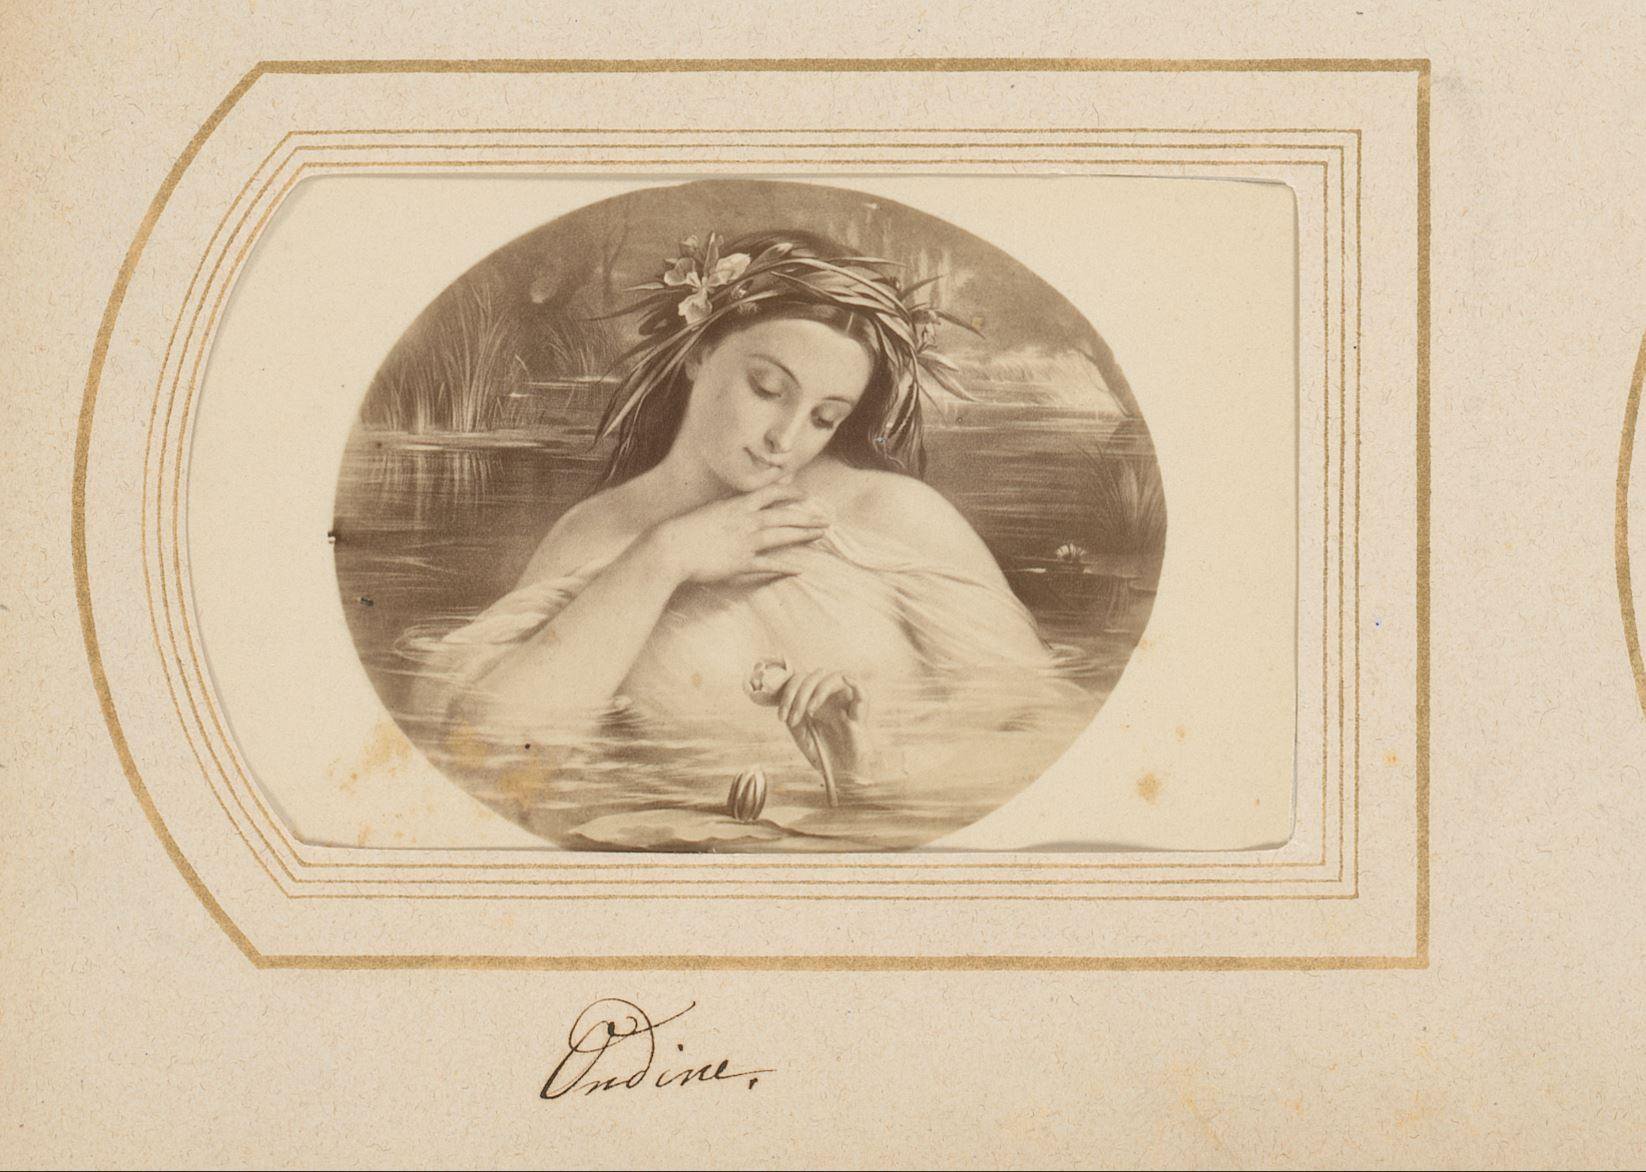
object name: reproduction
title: Fotoreproductie van Ondine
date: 1870-1890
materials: cardboard, photographic support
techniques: albumen print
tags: spirit of water, nix, undine, painting, drawing and the graphic arts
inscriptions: annotation: ‘Ondine’, number: ‘2992’